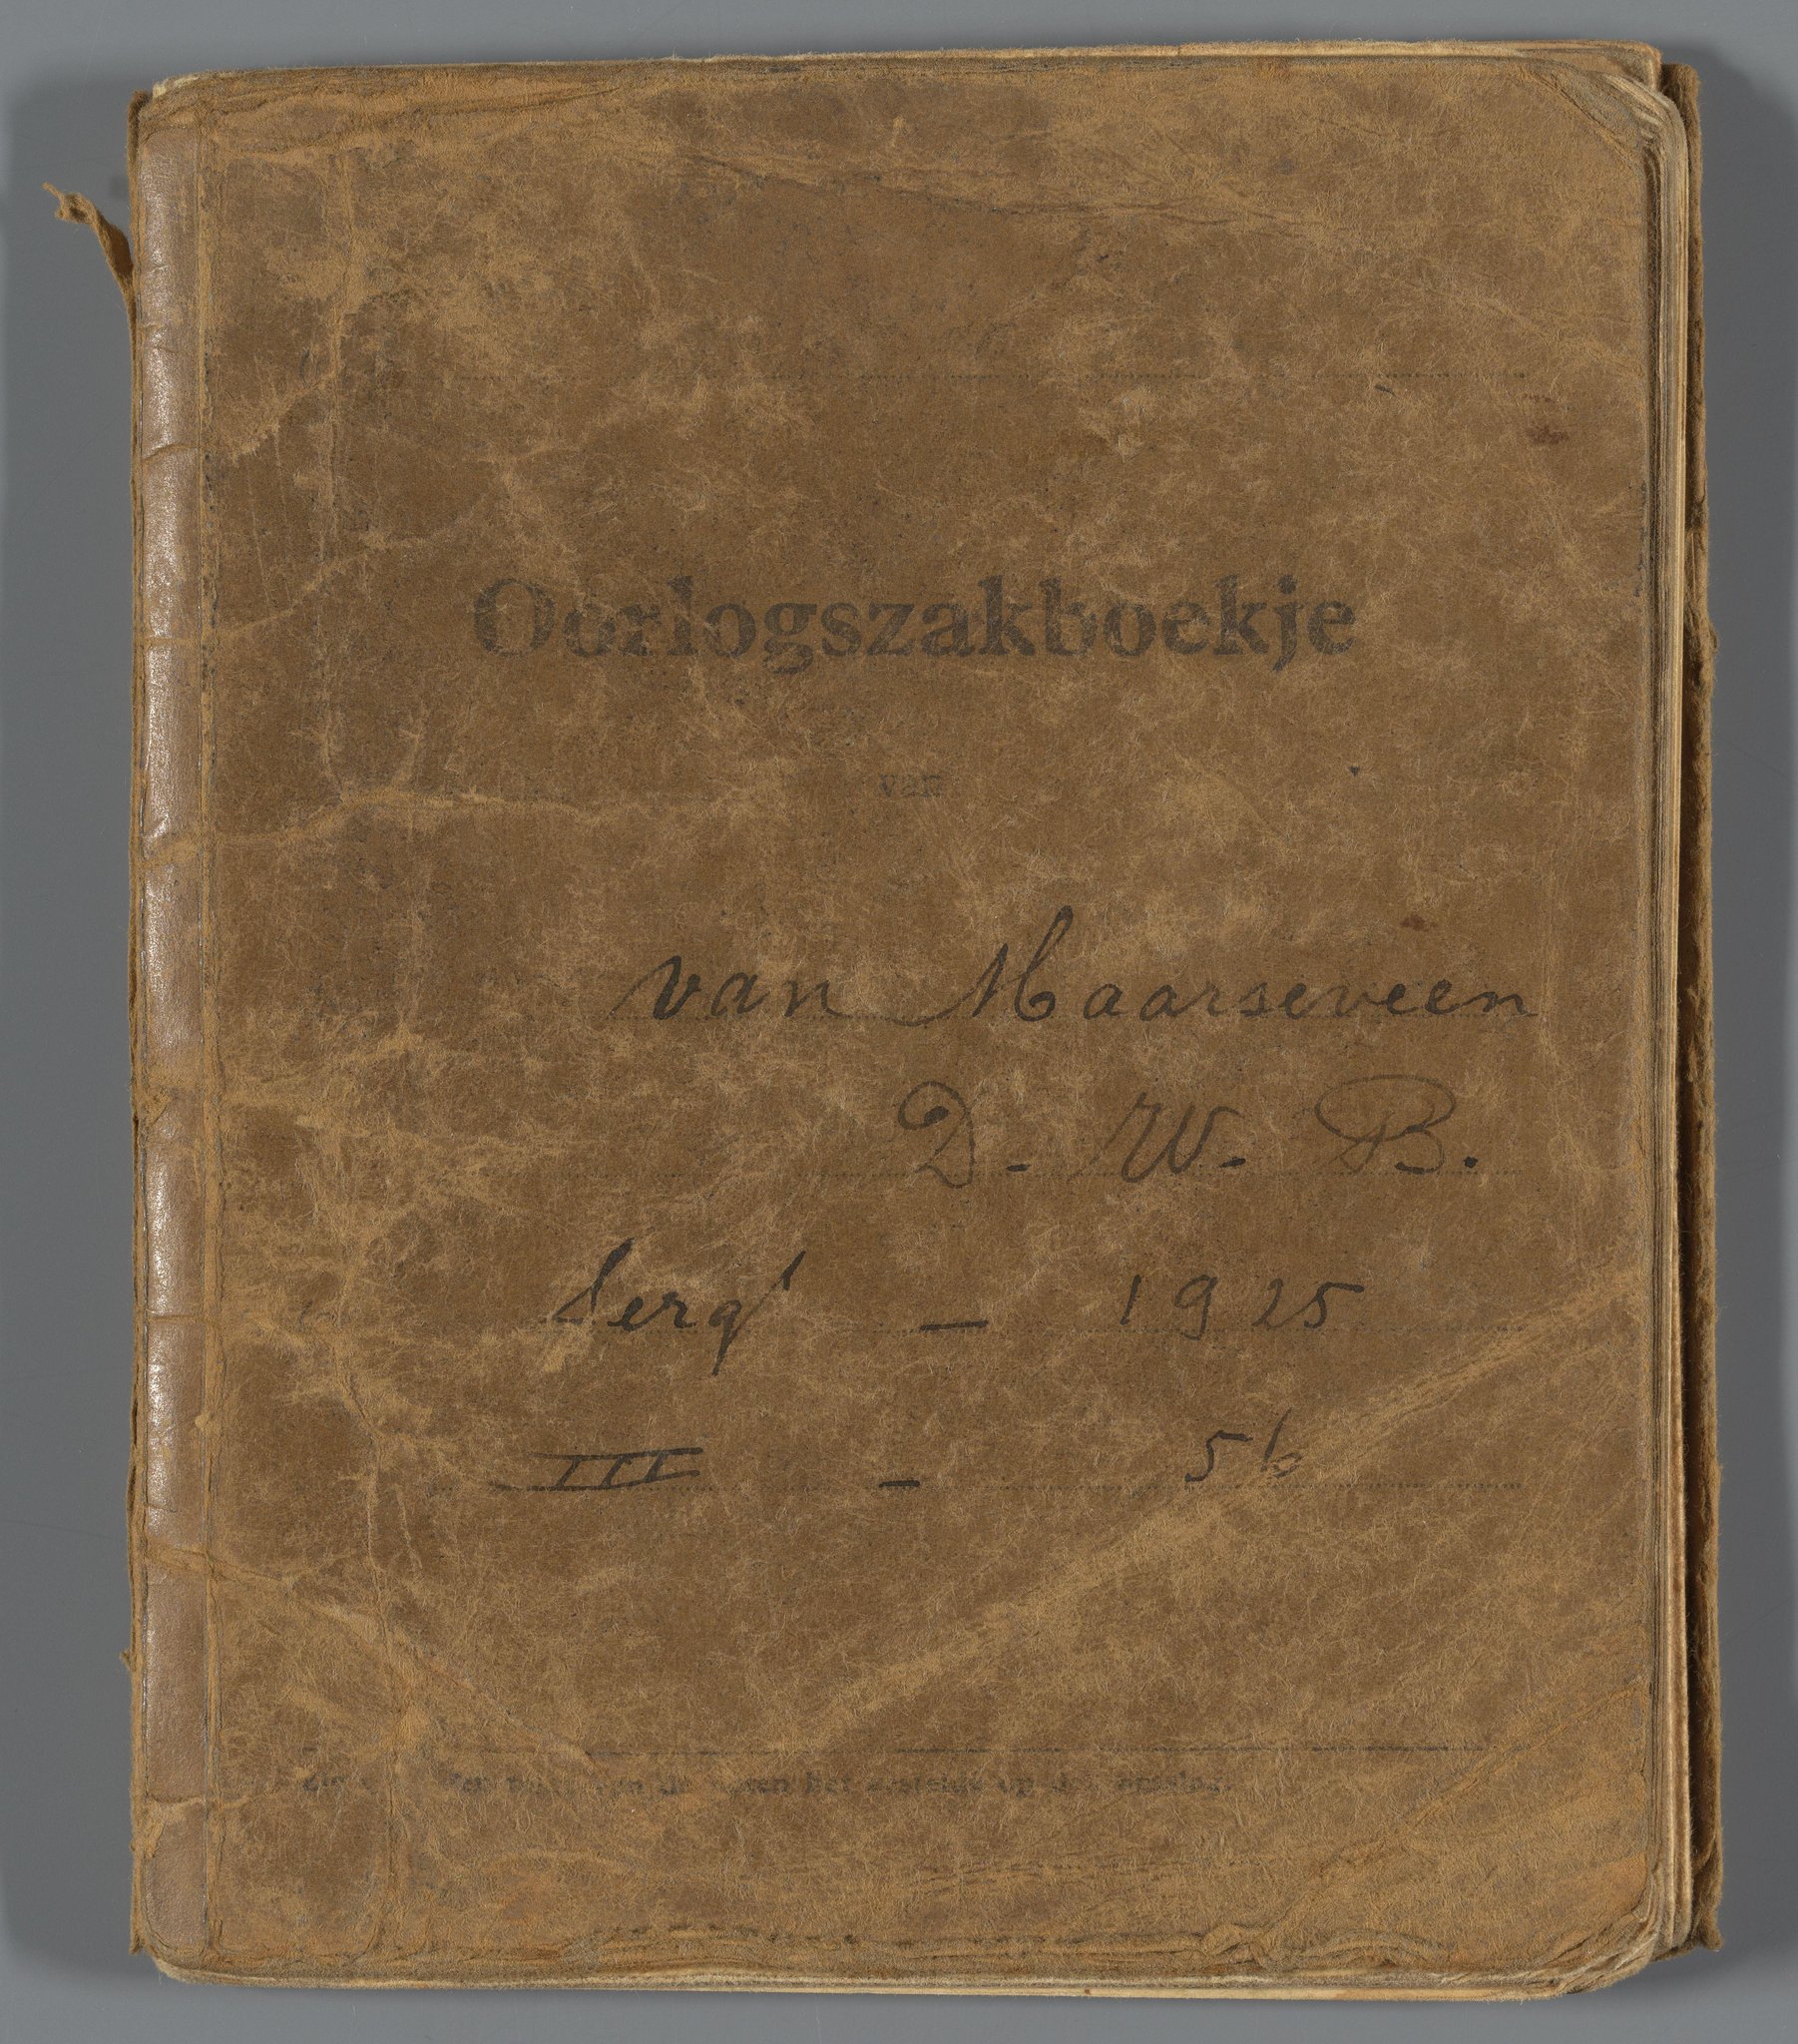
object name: paybook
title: Oorlogszakboekje van D.W.B. van Maarseveen, sergeant van het regiment grenadiers, III - 5b, uitgegeven 1925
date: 1925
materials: cardboard, paper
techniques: printing, sewing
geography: netherlands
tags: the hague, dick w.b. van maarseveen, prisoner of war camp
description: Boekje met bruine kartonnen kaft met 54 pagina's waarin de gegevens van Van Maarseveen, een uittreksel van het Geneefse verdrag over oorlogvoering, met name de behandeling van gevangenen, zieken en gewonden. Achterin 4 berichtkaarten voor het Nederlandse Rode Kruis. Losse formulieren: een bewijs van inschrijving voor de dienstplicht gedateerd 18 januari 1924, een formulier 'model A' van de Vrijwillige Landstorm gedateerd 20 october 1924. Achterin adressen van medegevangenen in kamp Stalag IV B in Mühlberg.